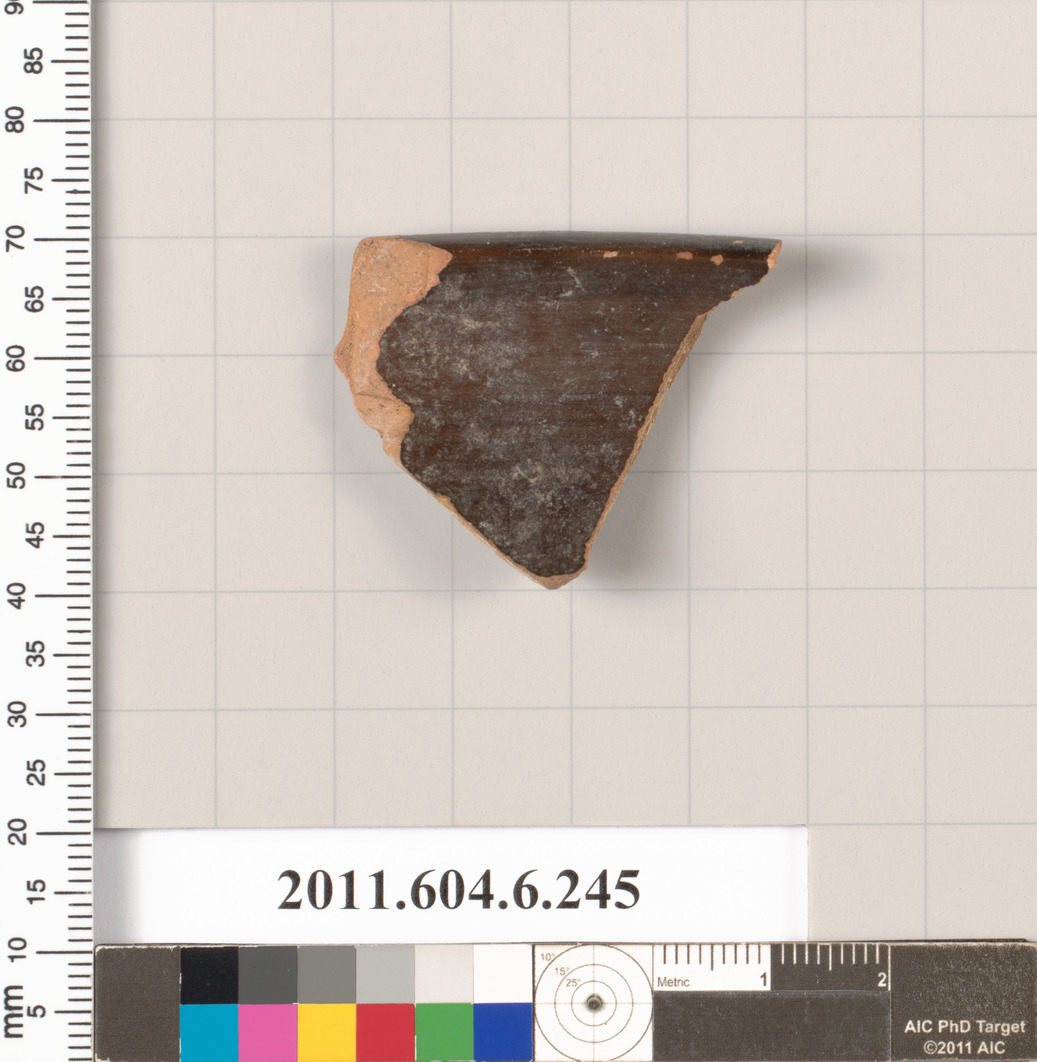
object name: undetermined open shape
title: Terracotta rim fragment of an open shape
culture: greek, attic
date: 600-301 BCE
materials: terracotta